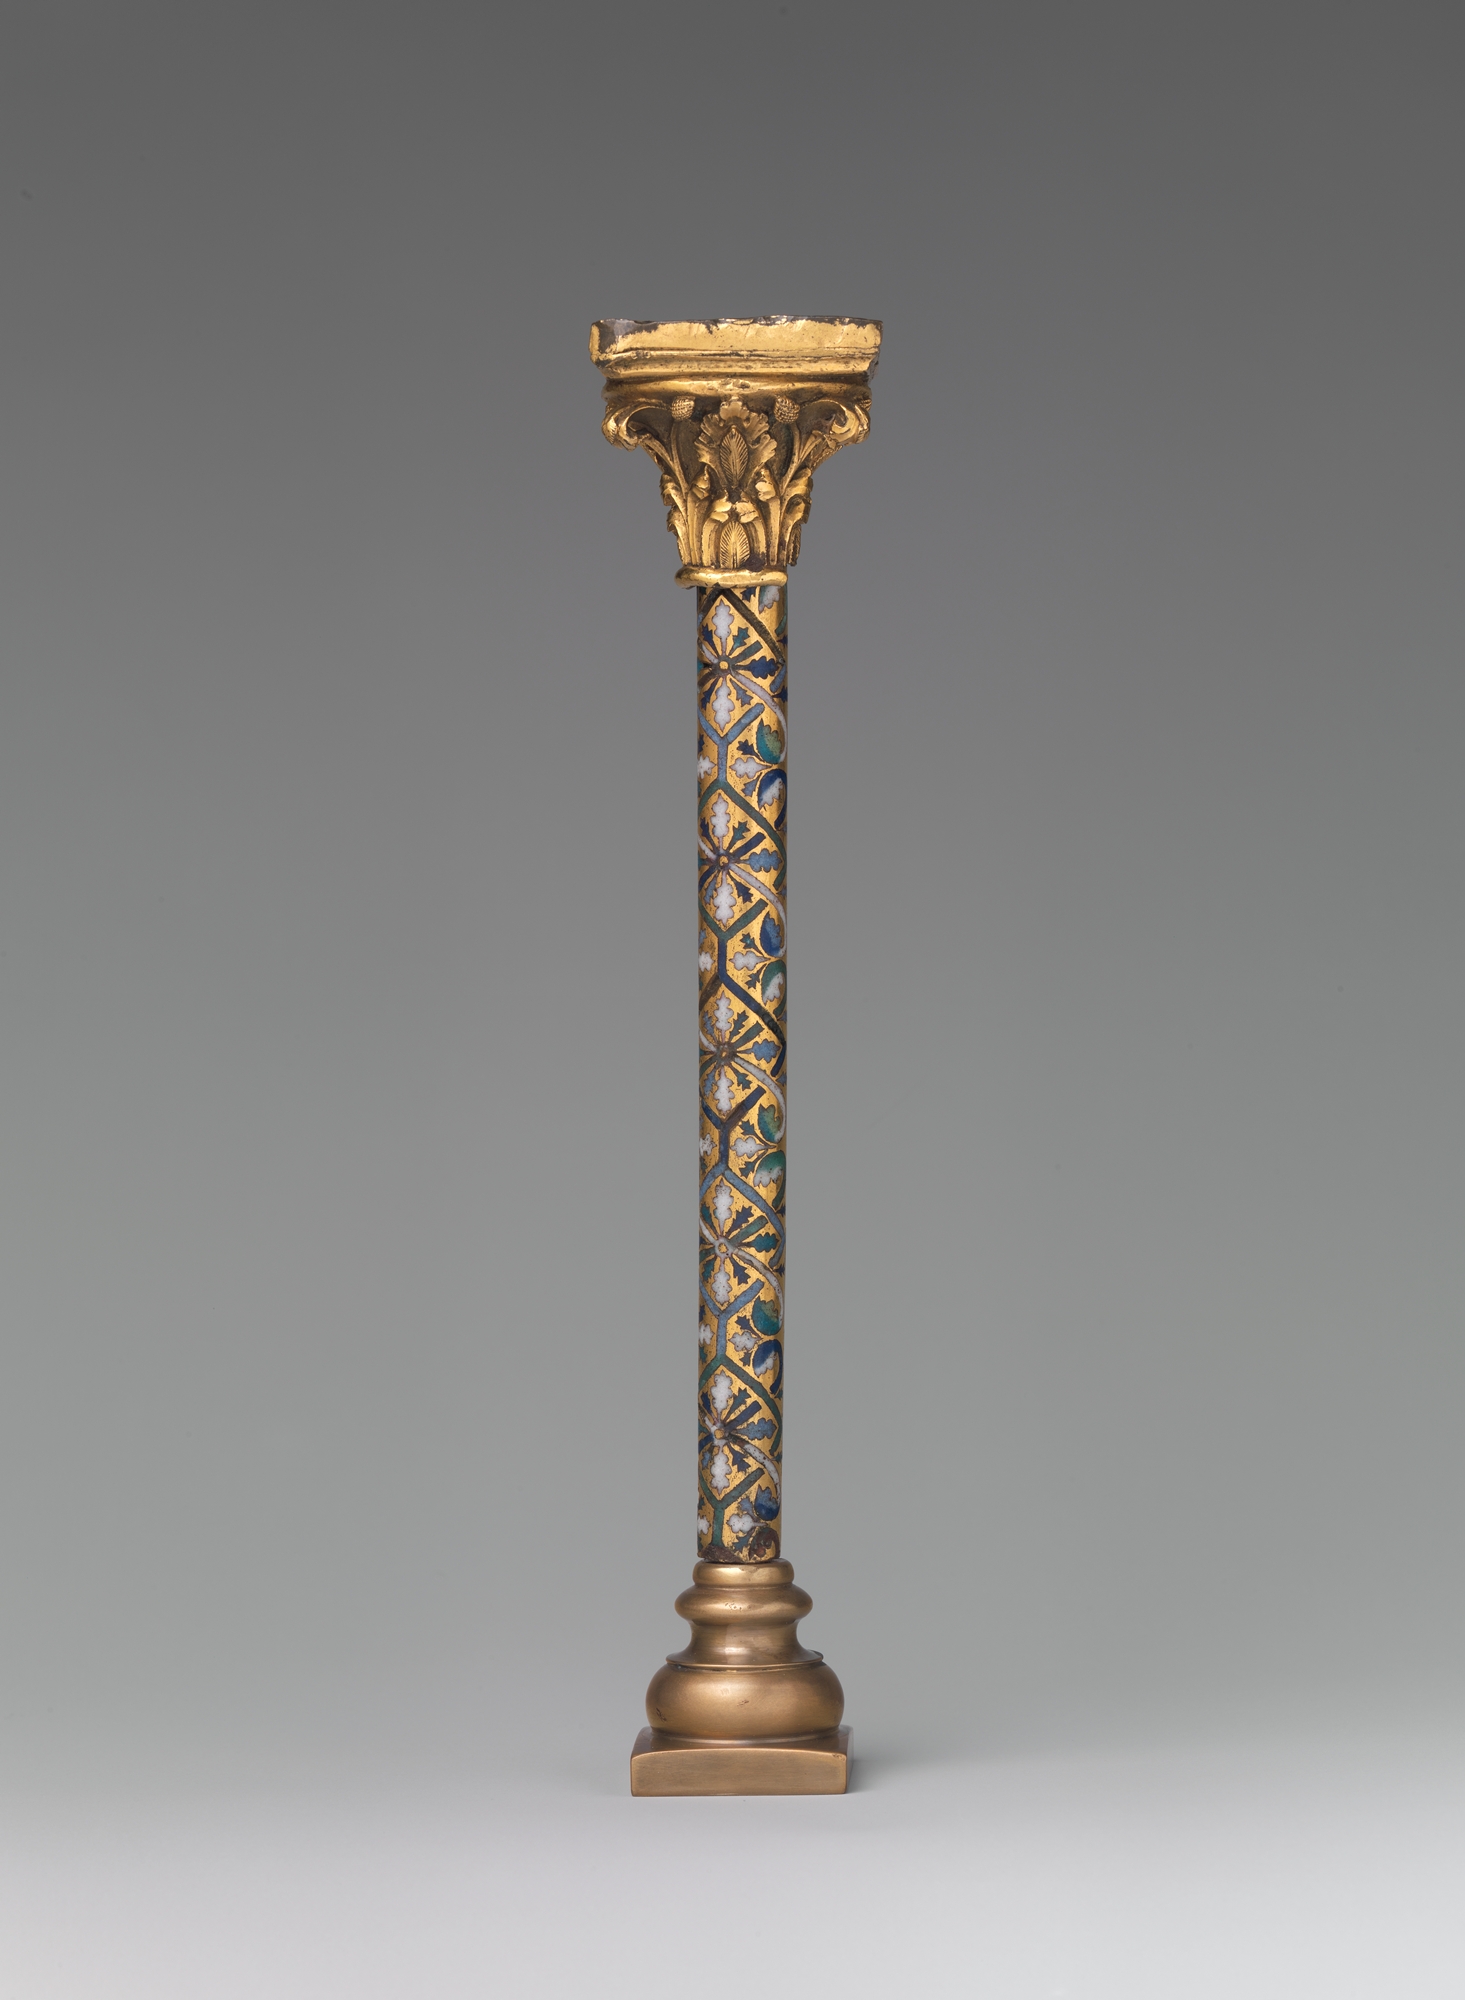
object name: colonnette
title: Colonnette from a Reliquary Shrine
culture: german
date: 1175-1200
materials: copper alloy, enamel, gilt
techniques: enamel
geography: germany